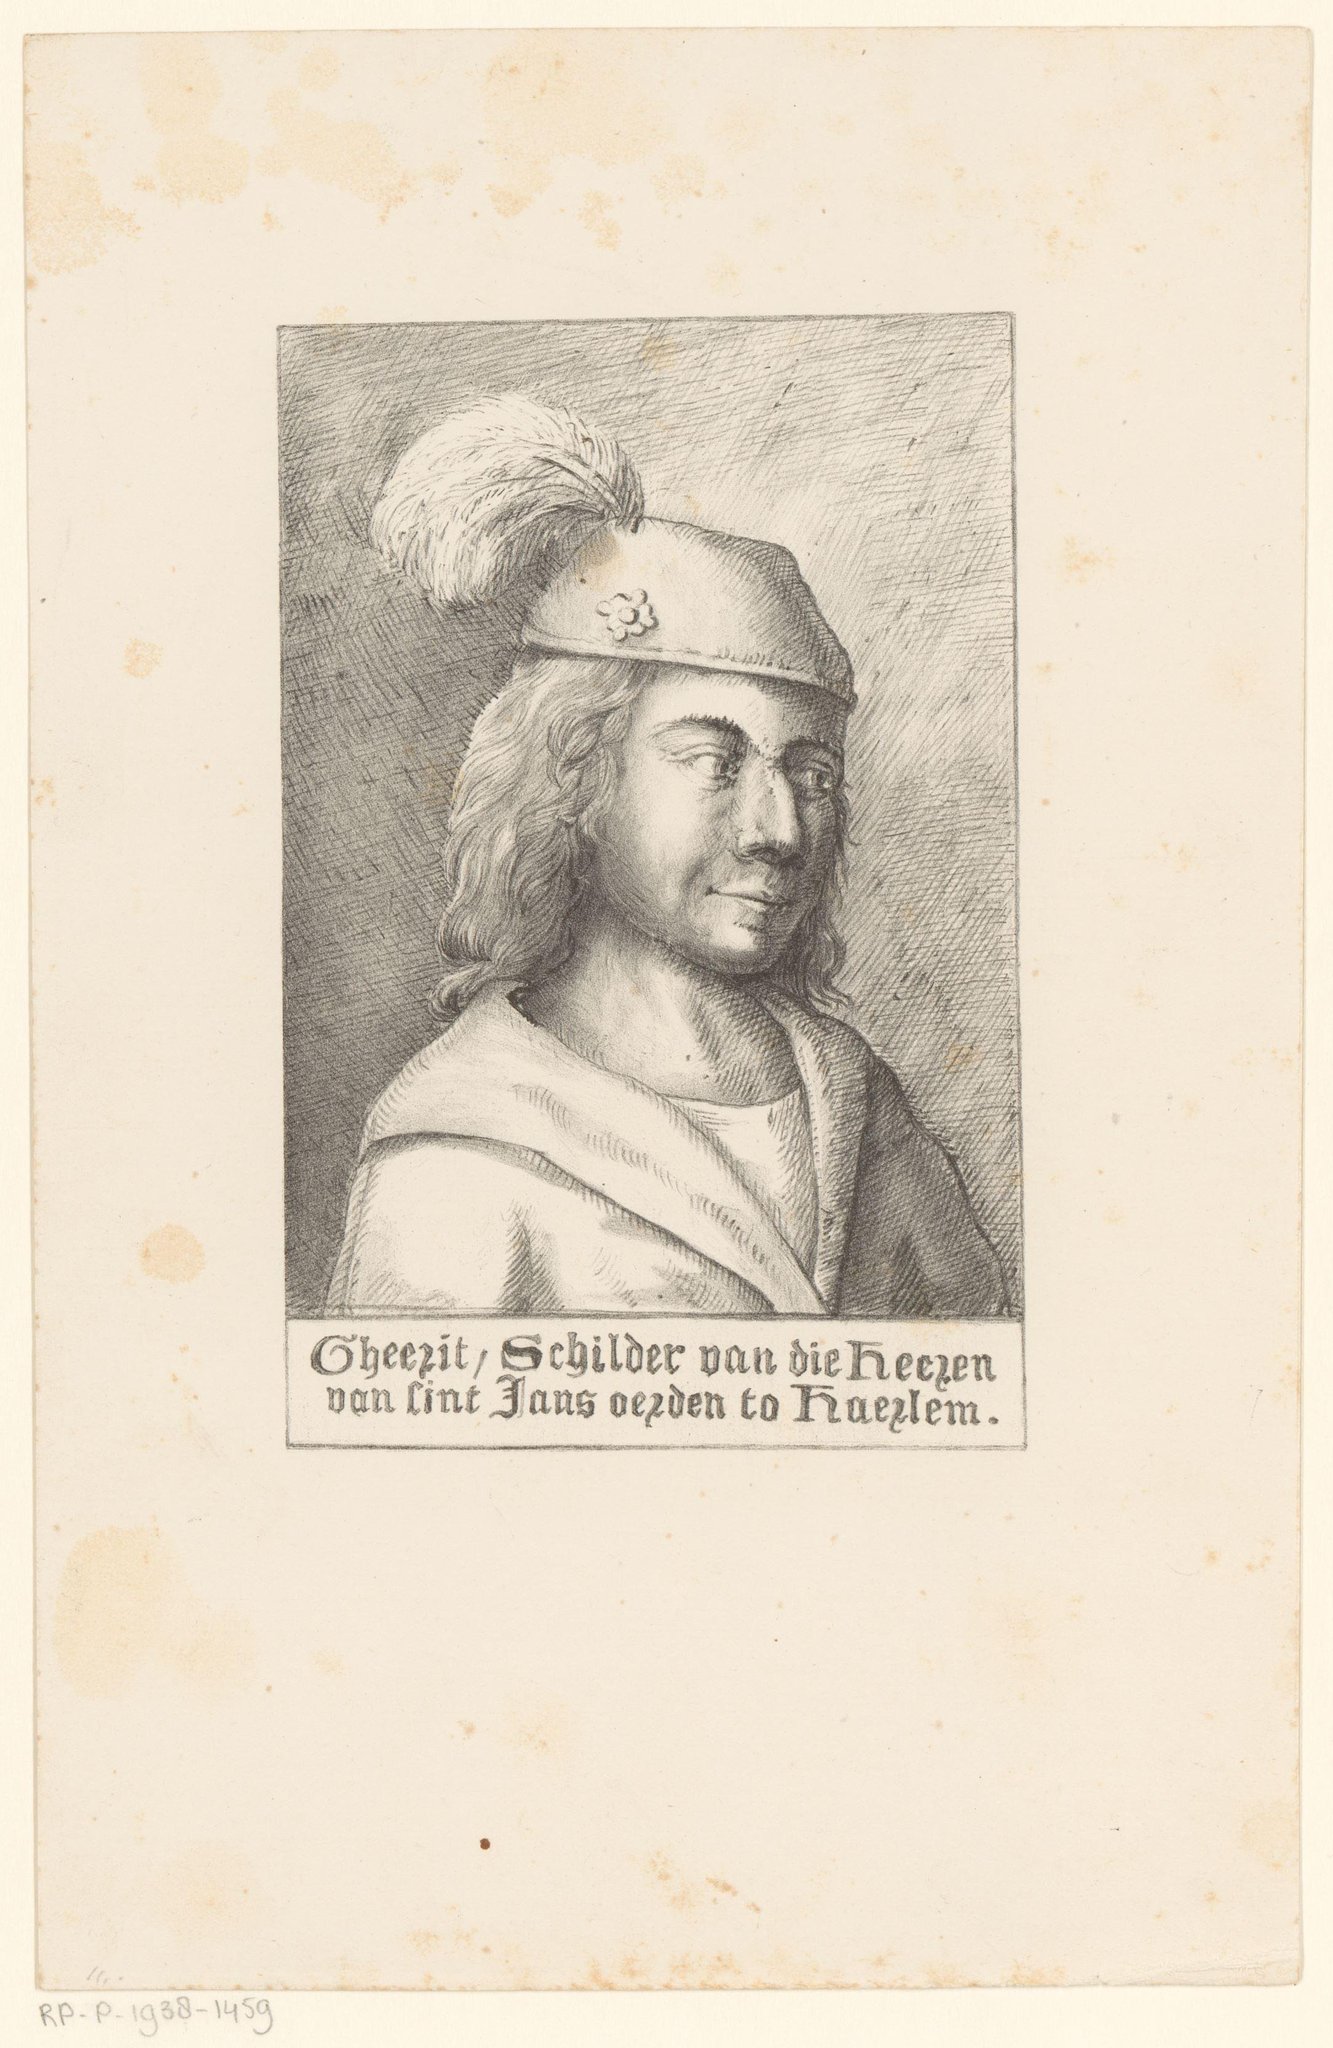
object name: print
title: Portret van Geertgen tot Sint Jans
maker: frederik hendrik weissenbruch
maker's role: draughtsman, print maker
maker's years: 1828-1887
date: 1838-1887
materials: paper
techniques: lithograph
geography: the hague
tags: haarlem, painter, geertgen tot sint jans, historical persons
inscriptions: collector's mark: Lugt 2228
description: Diverse proefdrukken in de collectie, zie RP-P-1938-1457 t/m 1965.